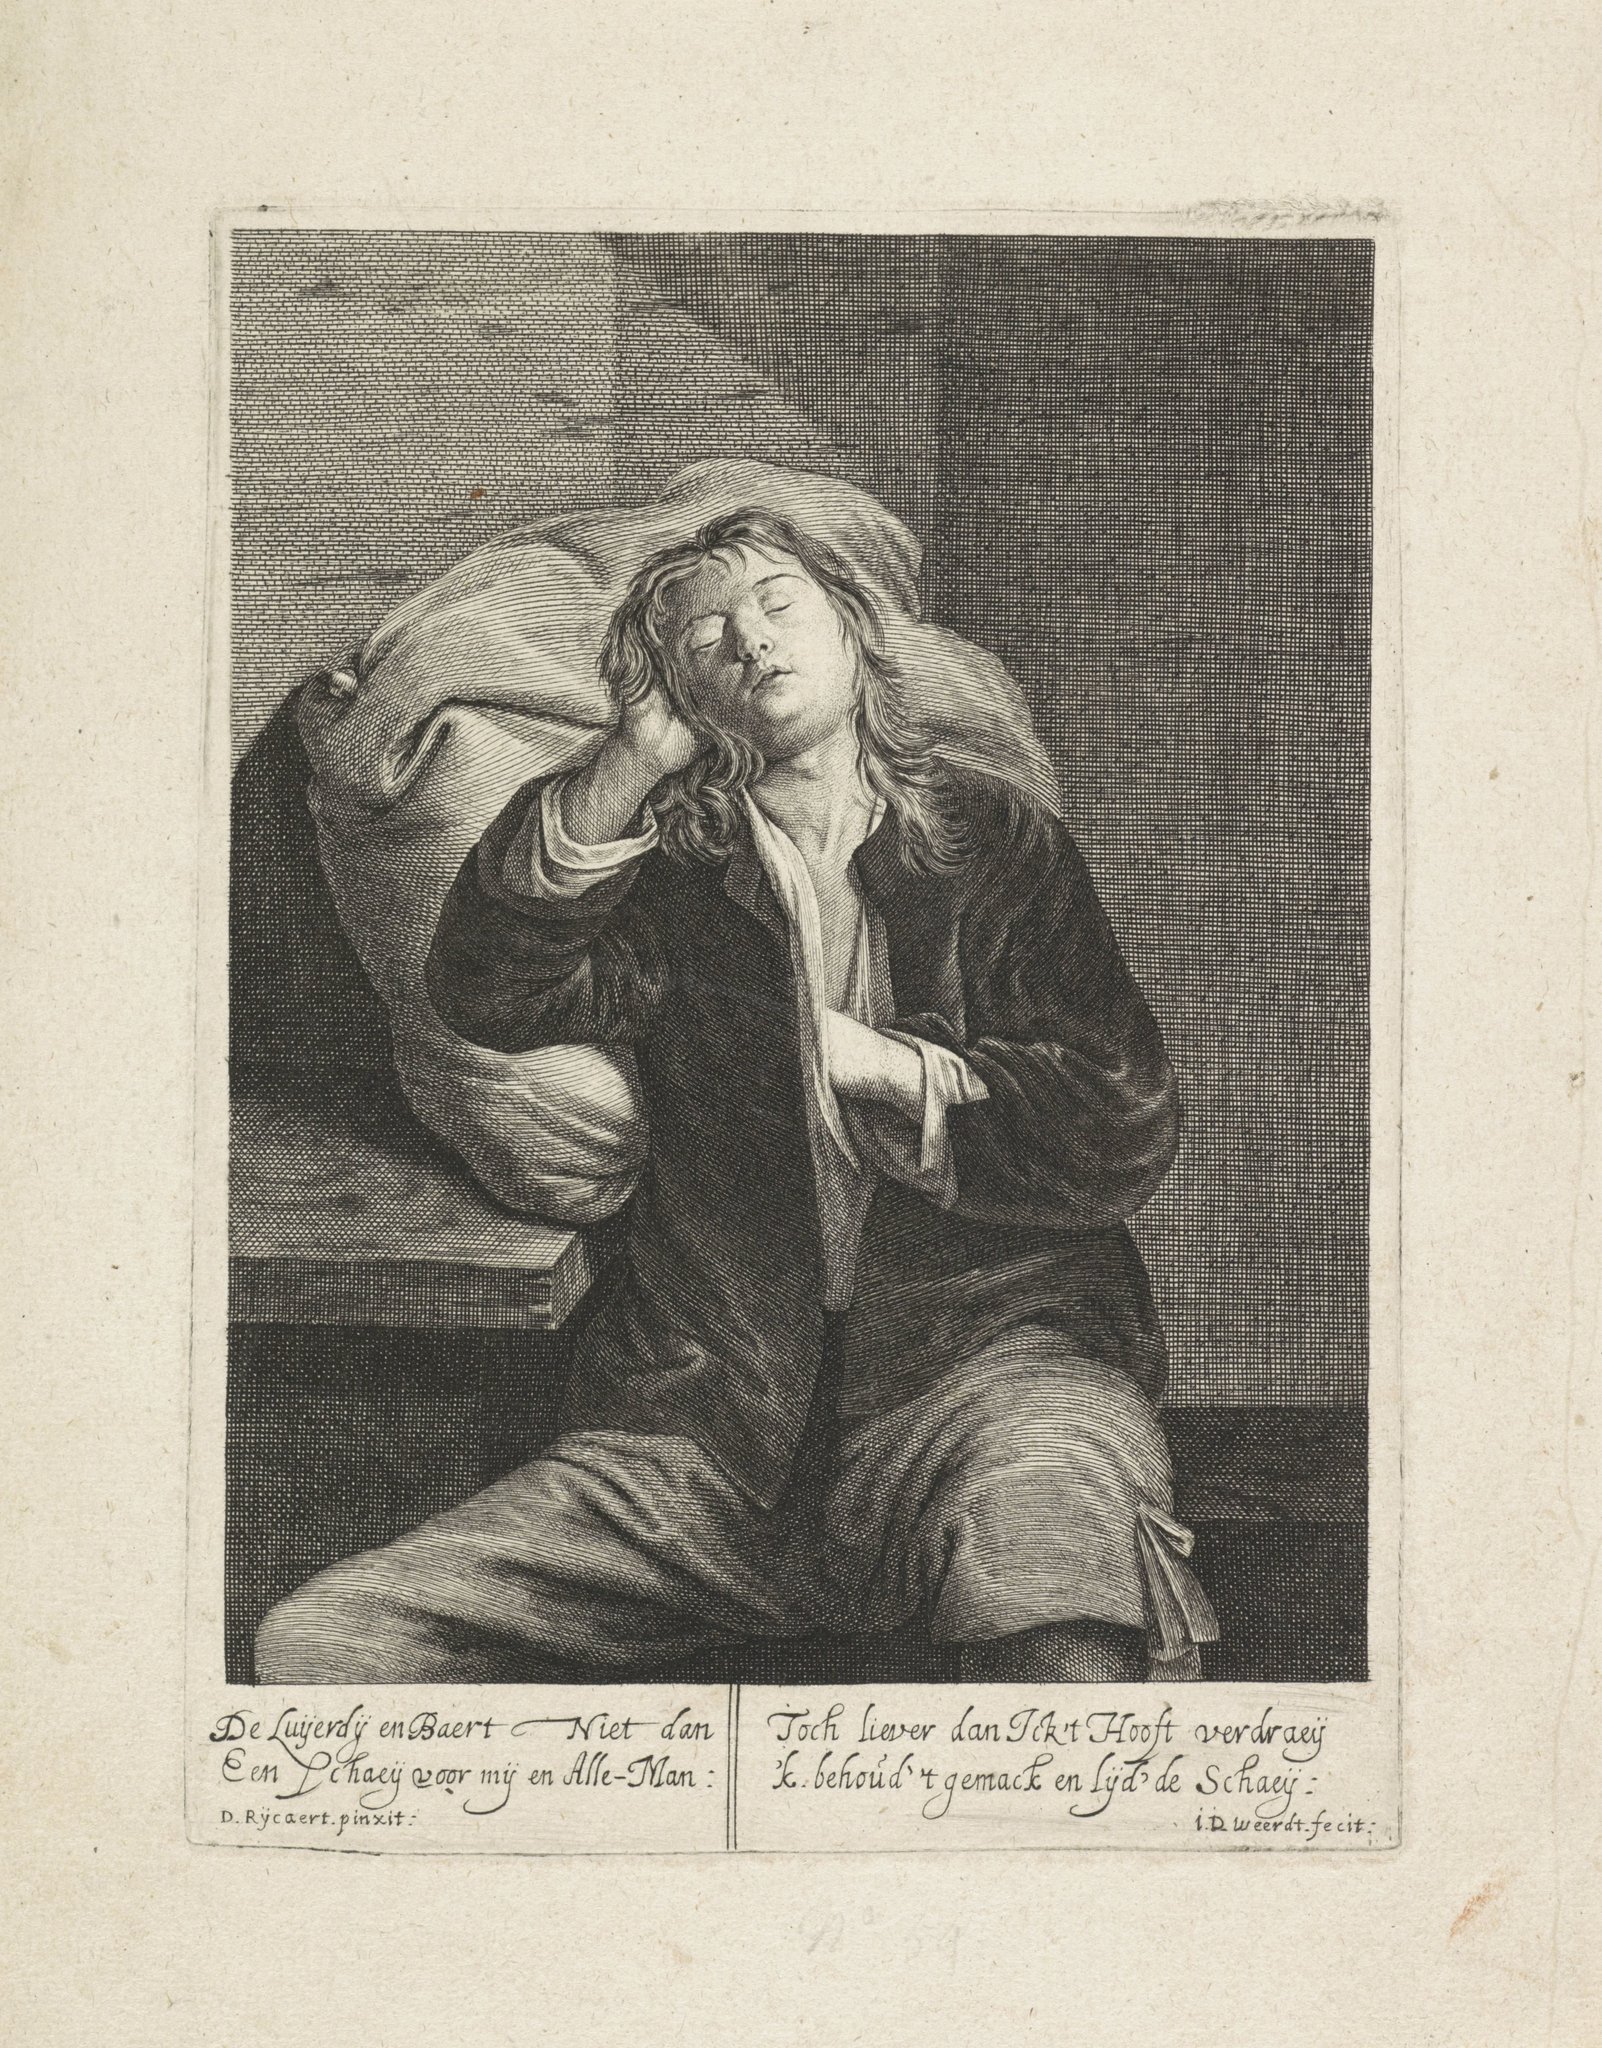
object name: print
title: Zeven zonden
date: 1636-1700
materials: paper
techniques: engraving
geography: antwerp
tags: sleeping in chair, sloth, indolence, 'acedia', 'desidia'; 'accidia' (ripa) ~ personification of one of the seven deadly sins, youth, adolescent, pillow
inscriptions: collector's mark: Lugt 240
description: Een slapende jonge man zit tegen een kussen aan en ondersteunt zijn hoofd met zijn hand. Onder de voorstelling bevindt zich een vierregelig, Nederlandstalig gedicht.